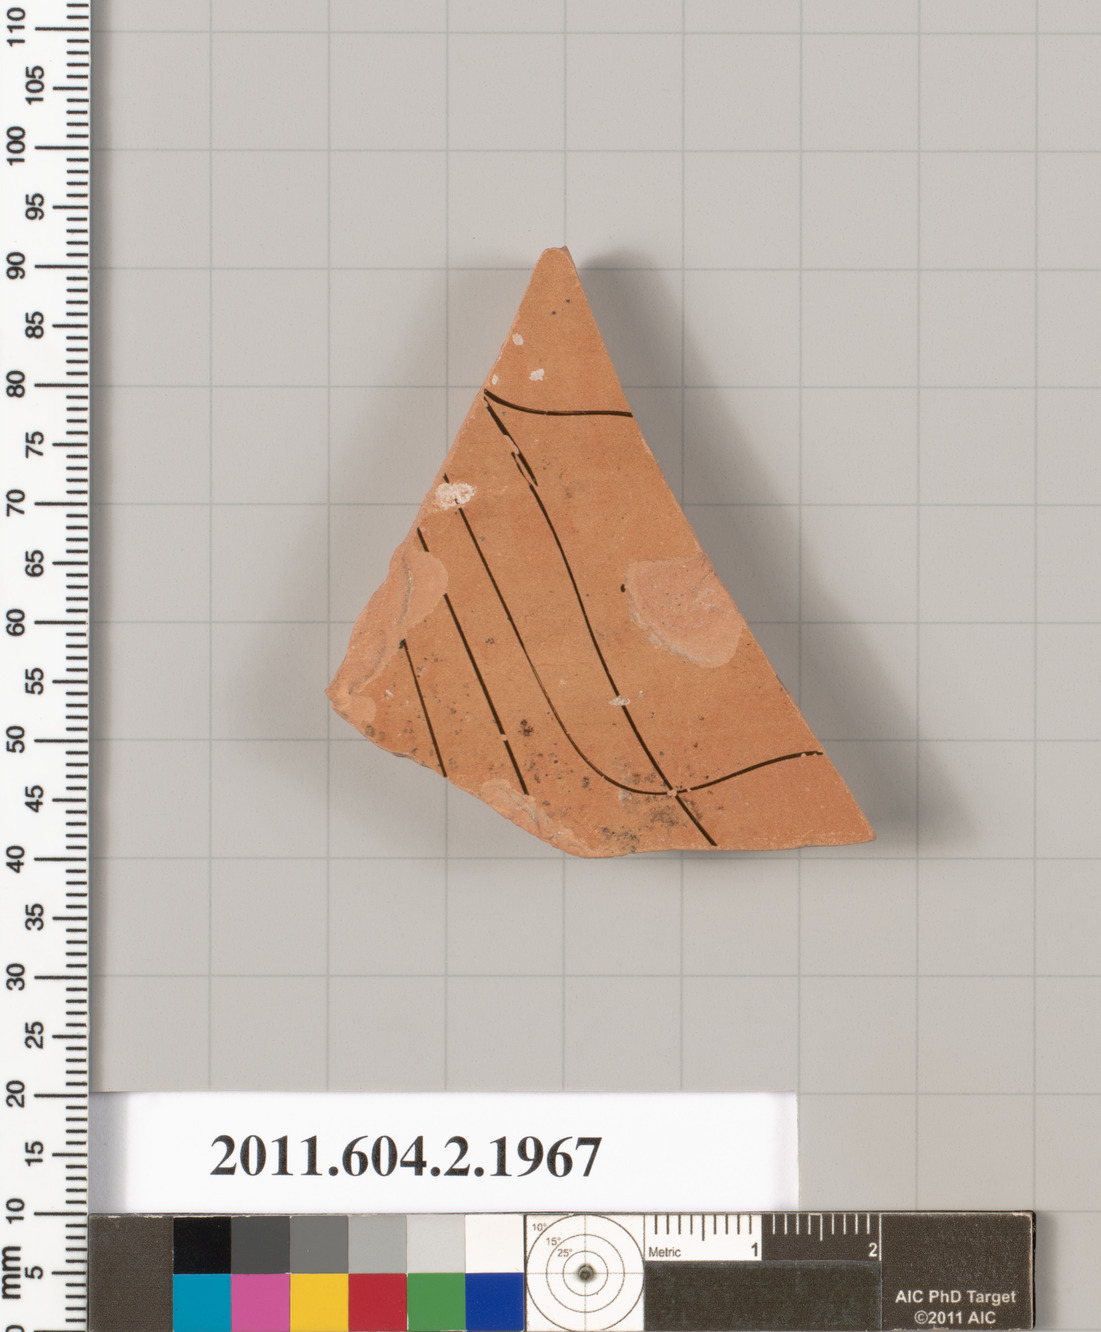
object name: krater fragment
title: Terracotta fragment of a krater (bowl for mixing wine and water)?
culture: greek, attic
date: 475-451 BCE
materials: terracotta